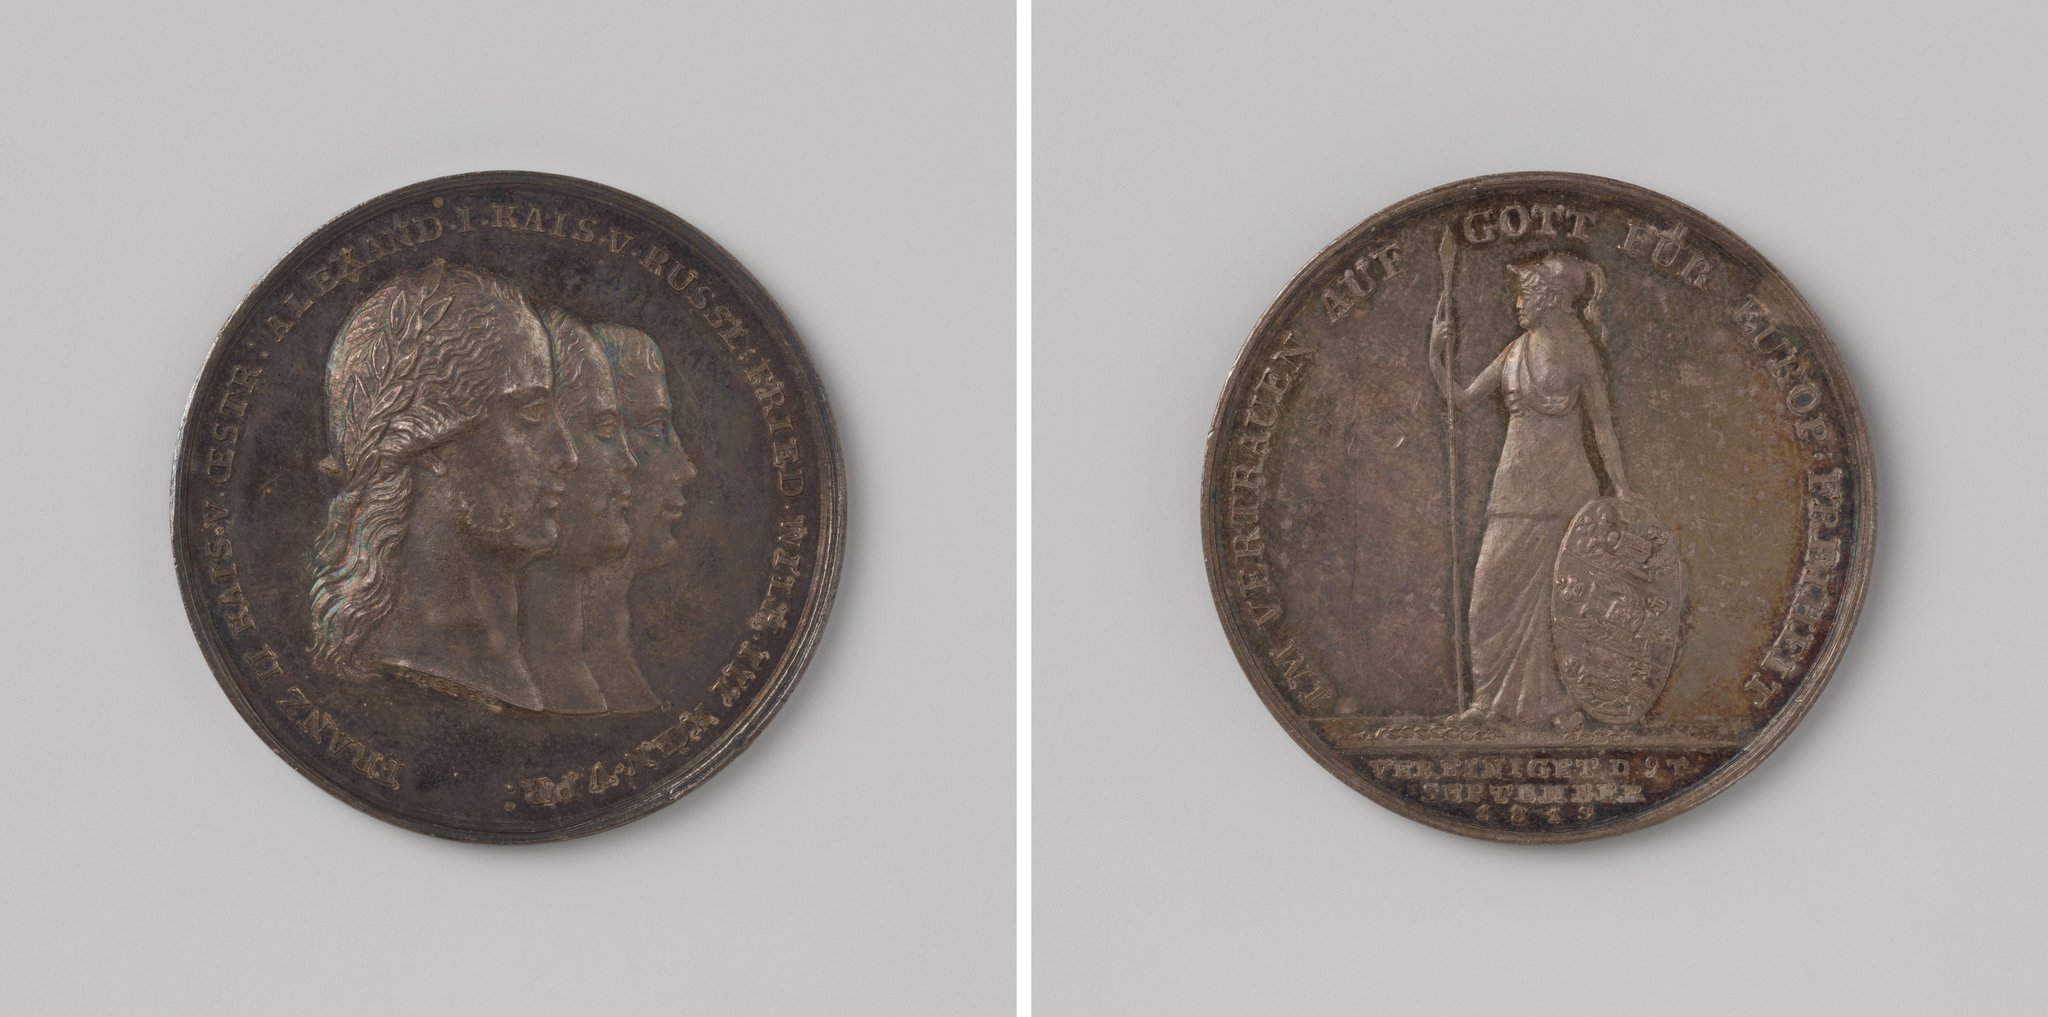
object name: history medal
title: Verdrag van Teplitz, ter ere van Alexander I, tsaar van Rusland, Frans I, keizer van Oostenrijk en Frederik Willem III, koning van Pruisen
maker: karl lesser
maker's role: medailleur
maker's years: 1782-1849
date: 1813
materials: silver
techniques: striking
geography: wroclaw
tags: vienna, frans ii (rooms-duits keizer), alexander i (tsaar van rusland), berlin, frederik willem iii koning van pruisen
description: Zilveren penning. Voorzijde: borststukken van drie mannen, waarvan voorste met lauwerkrans binnen omschrift. Keerzijde: gehelmde Minerva met speer en schild binnen omschrift; afsnede: opschrift